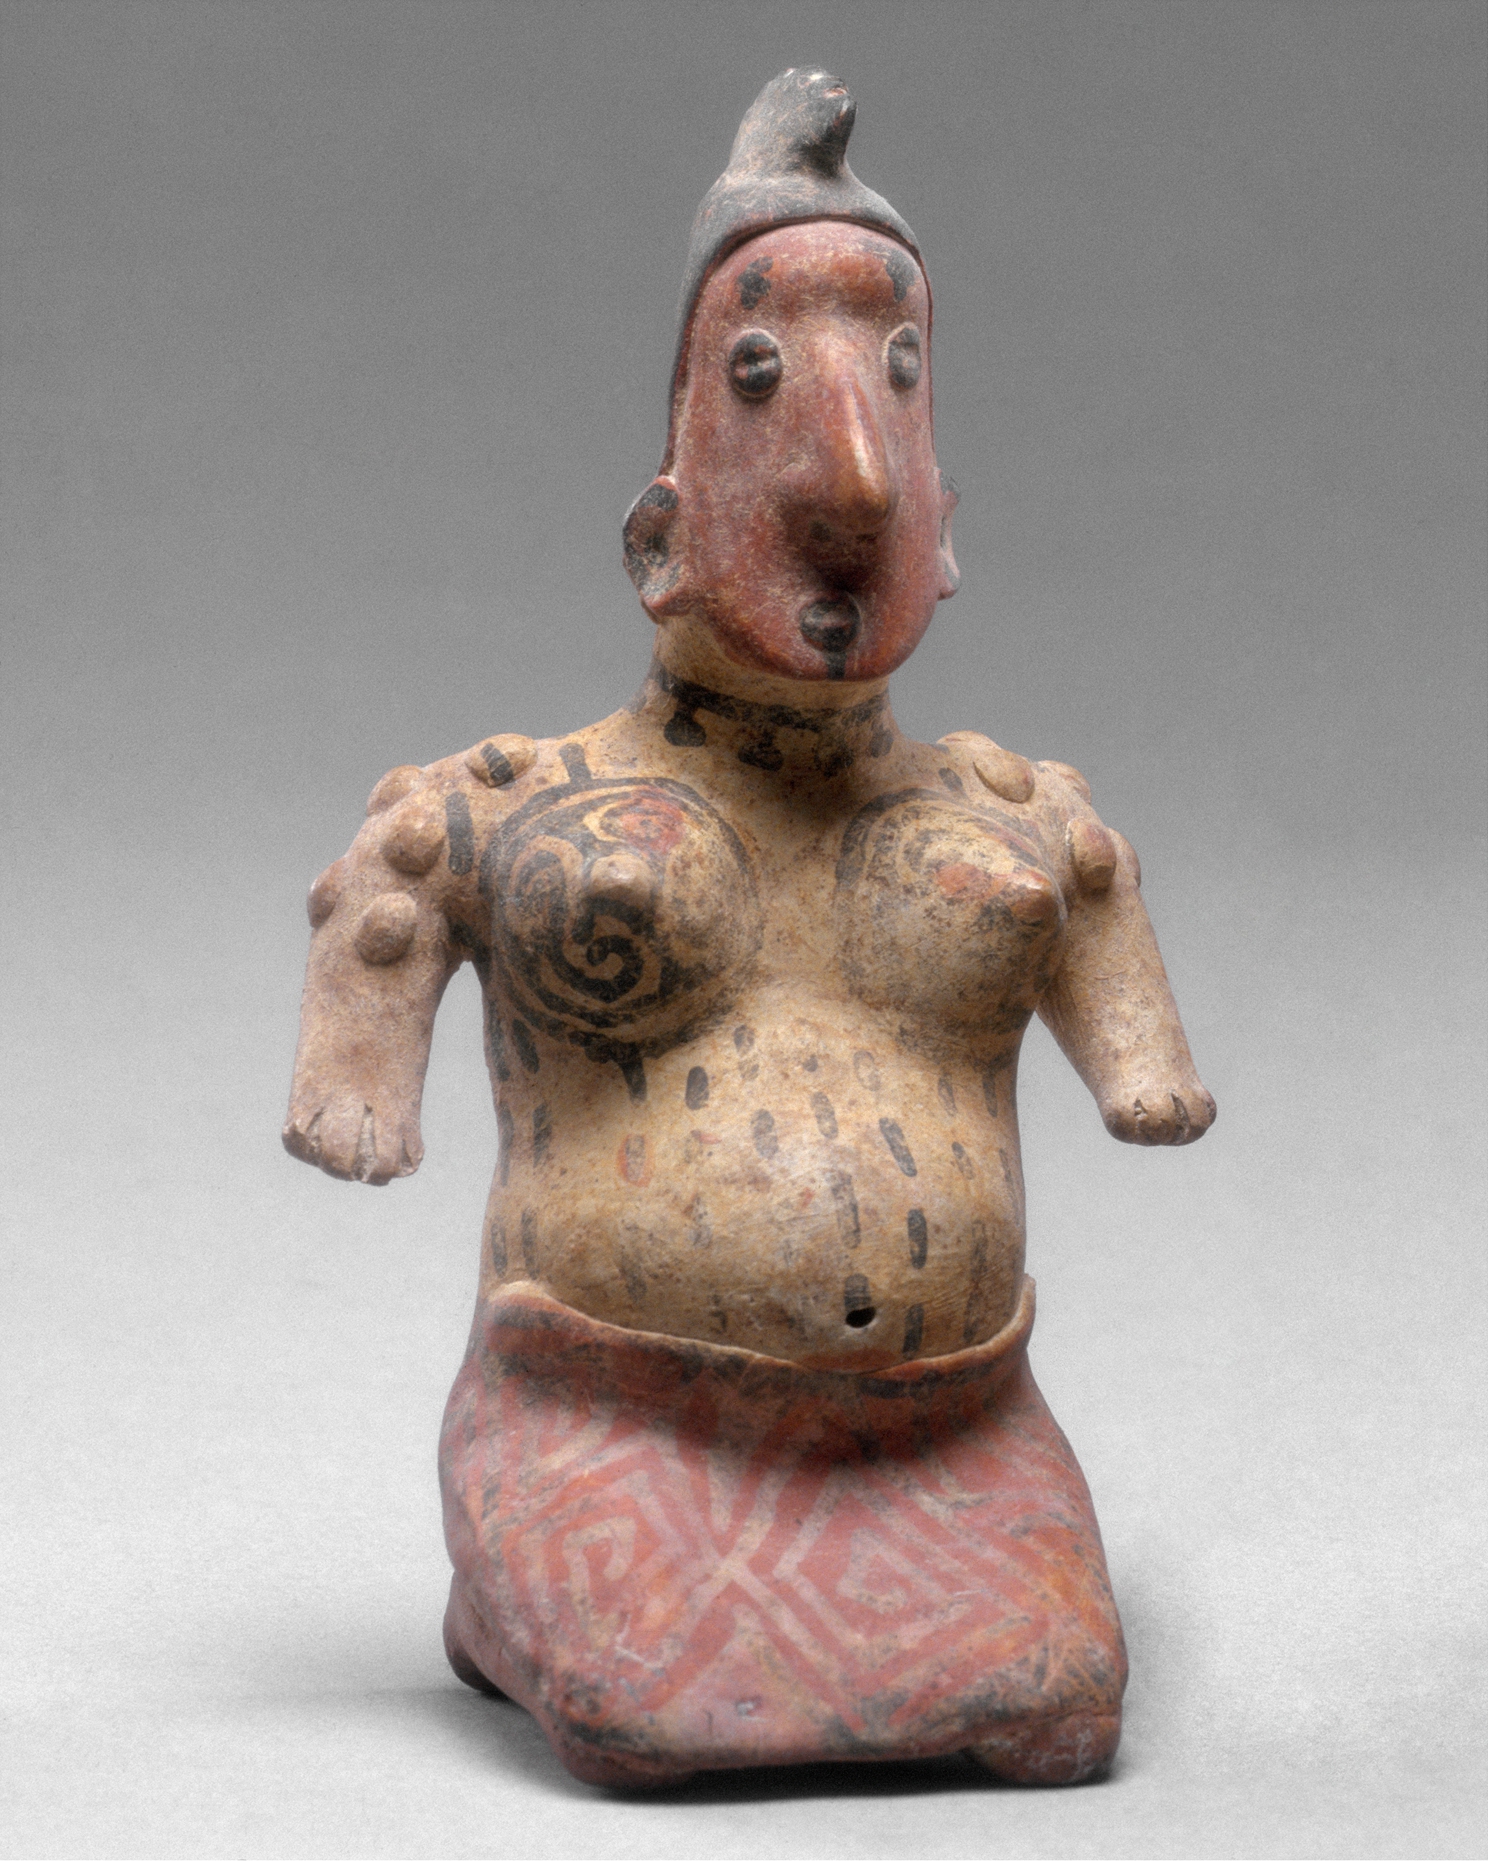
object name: female figure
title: Kneeling Female Figure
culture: san sebastián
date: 101-200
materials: ceramic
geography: mexico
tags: women